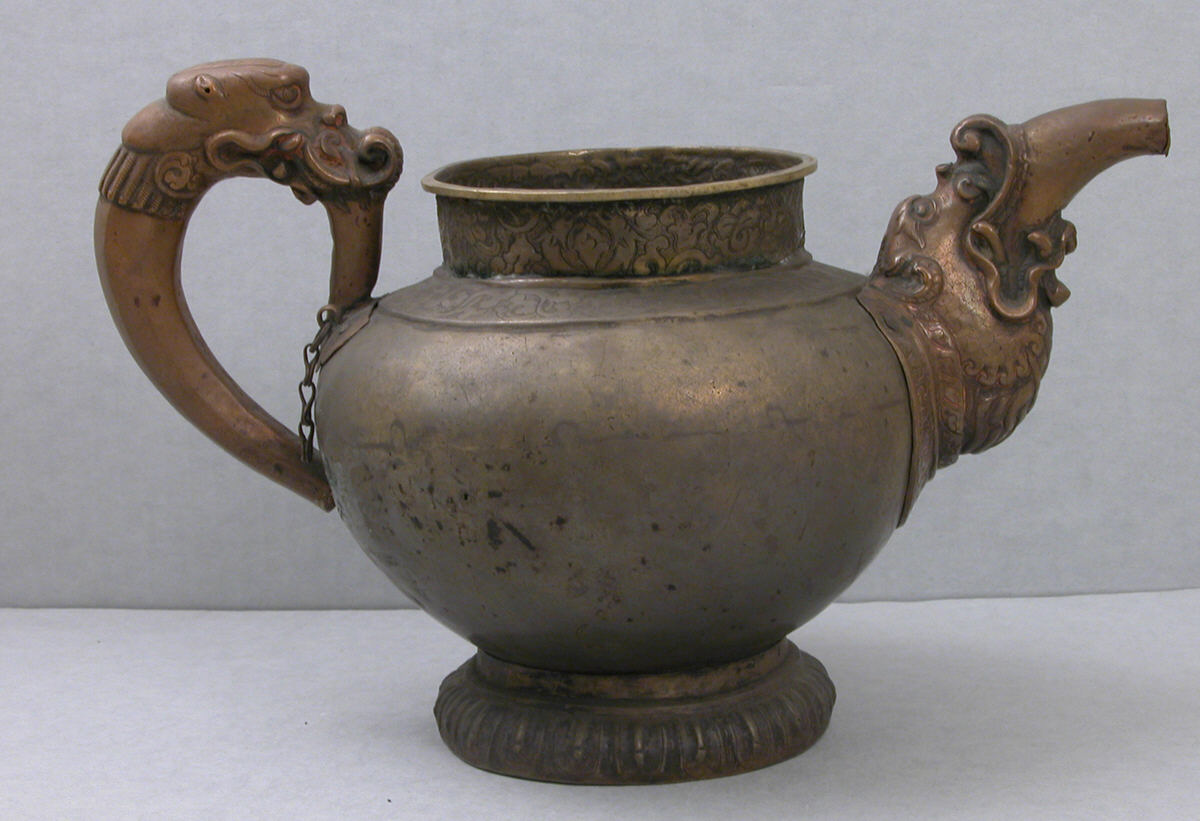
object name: teapot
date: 1701-1800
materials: brass, copper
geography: china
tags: teapots